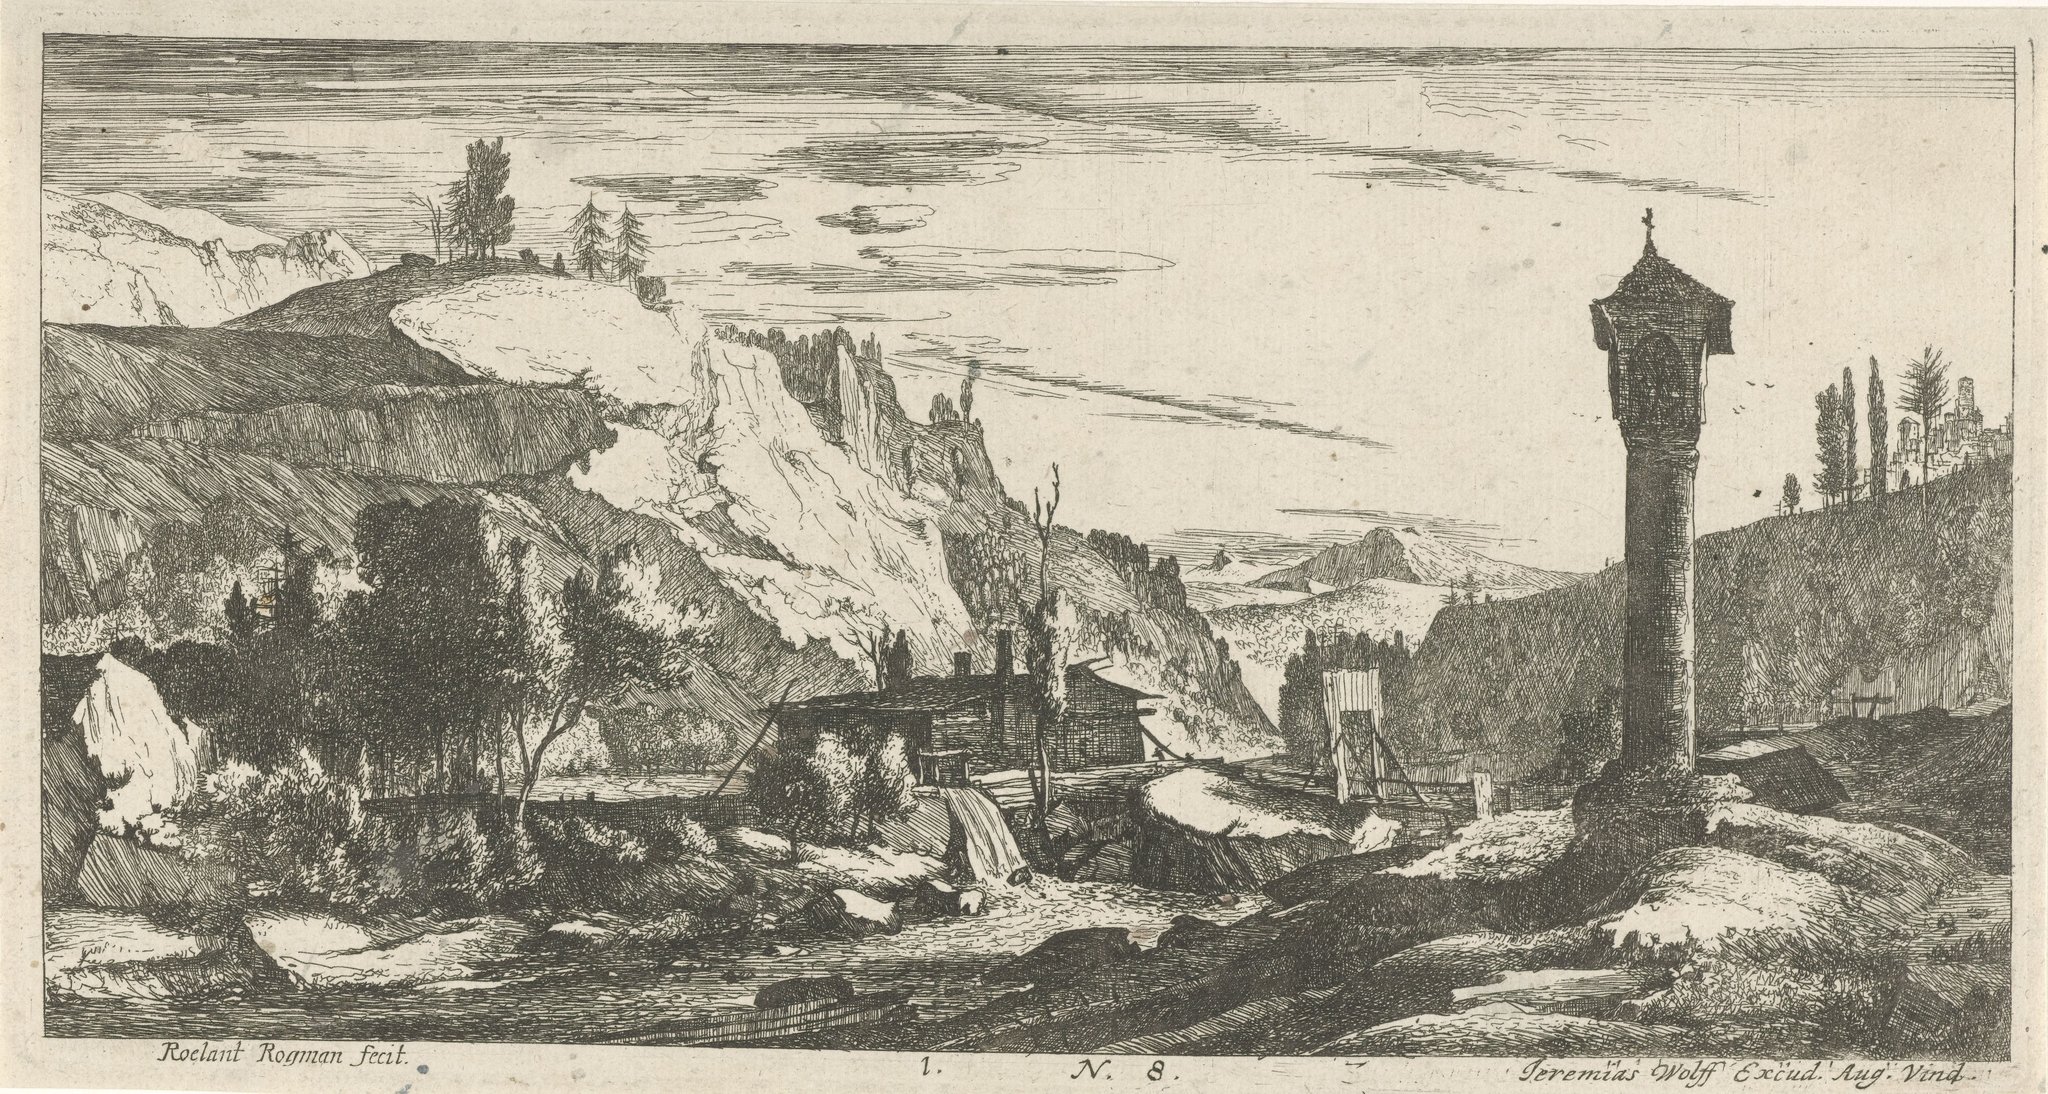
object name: print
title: Bergachtig landschap met zuil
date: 1673-1724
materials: paper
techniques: etching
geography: amsterdam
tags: column, pillar ~ architecture, landscape with bridge, viaduct or aqueduct, rural housing, e.g. country-house, villa, cottage, mountains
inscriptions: collector's mark: Lugt 2228a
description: Gezicht op een berglandschap in Tirol, met op de voorgrond een zuil met gedenkteken. Temidden van de bergen en rotsen een brug, die naar een hut bij een stroom leidt. Rechts op de achtergrond de contouren van een stad. Prent uit een serie van acht prenten met Tiroolse landschappen.